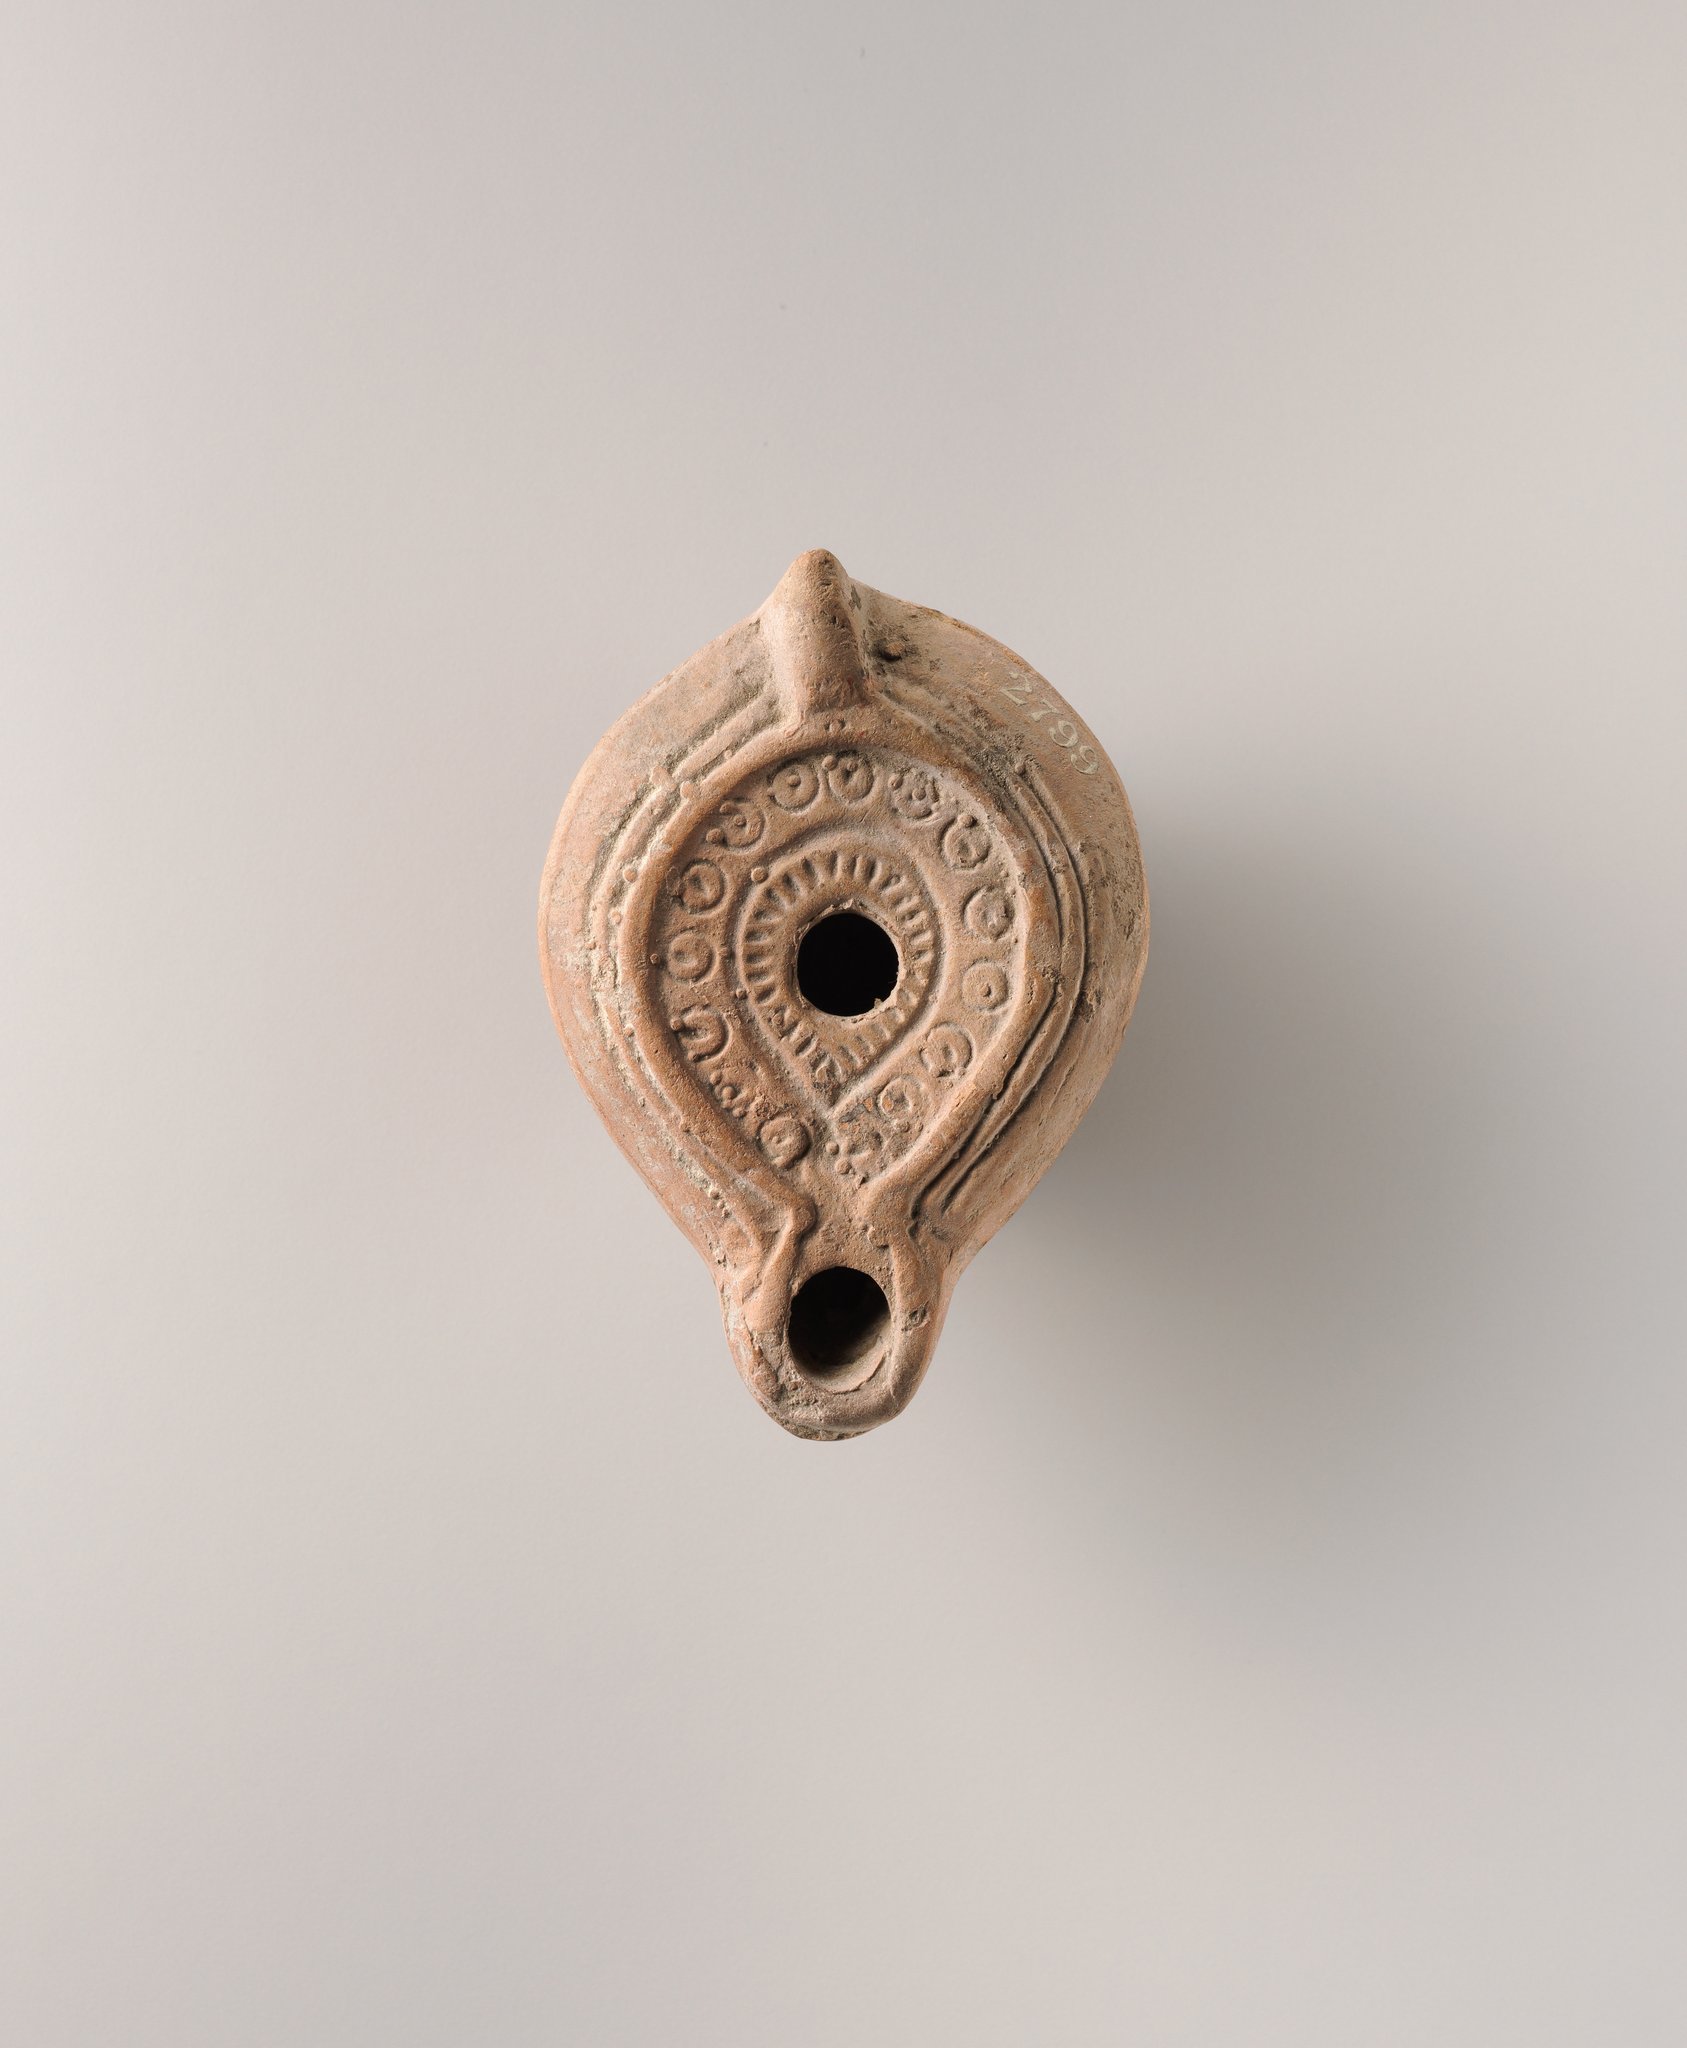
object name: lamp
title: Terracotta oil lamp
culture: roman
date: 201-300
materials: terracotta